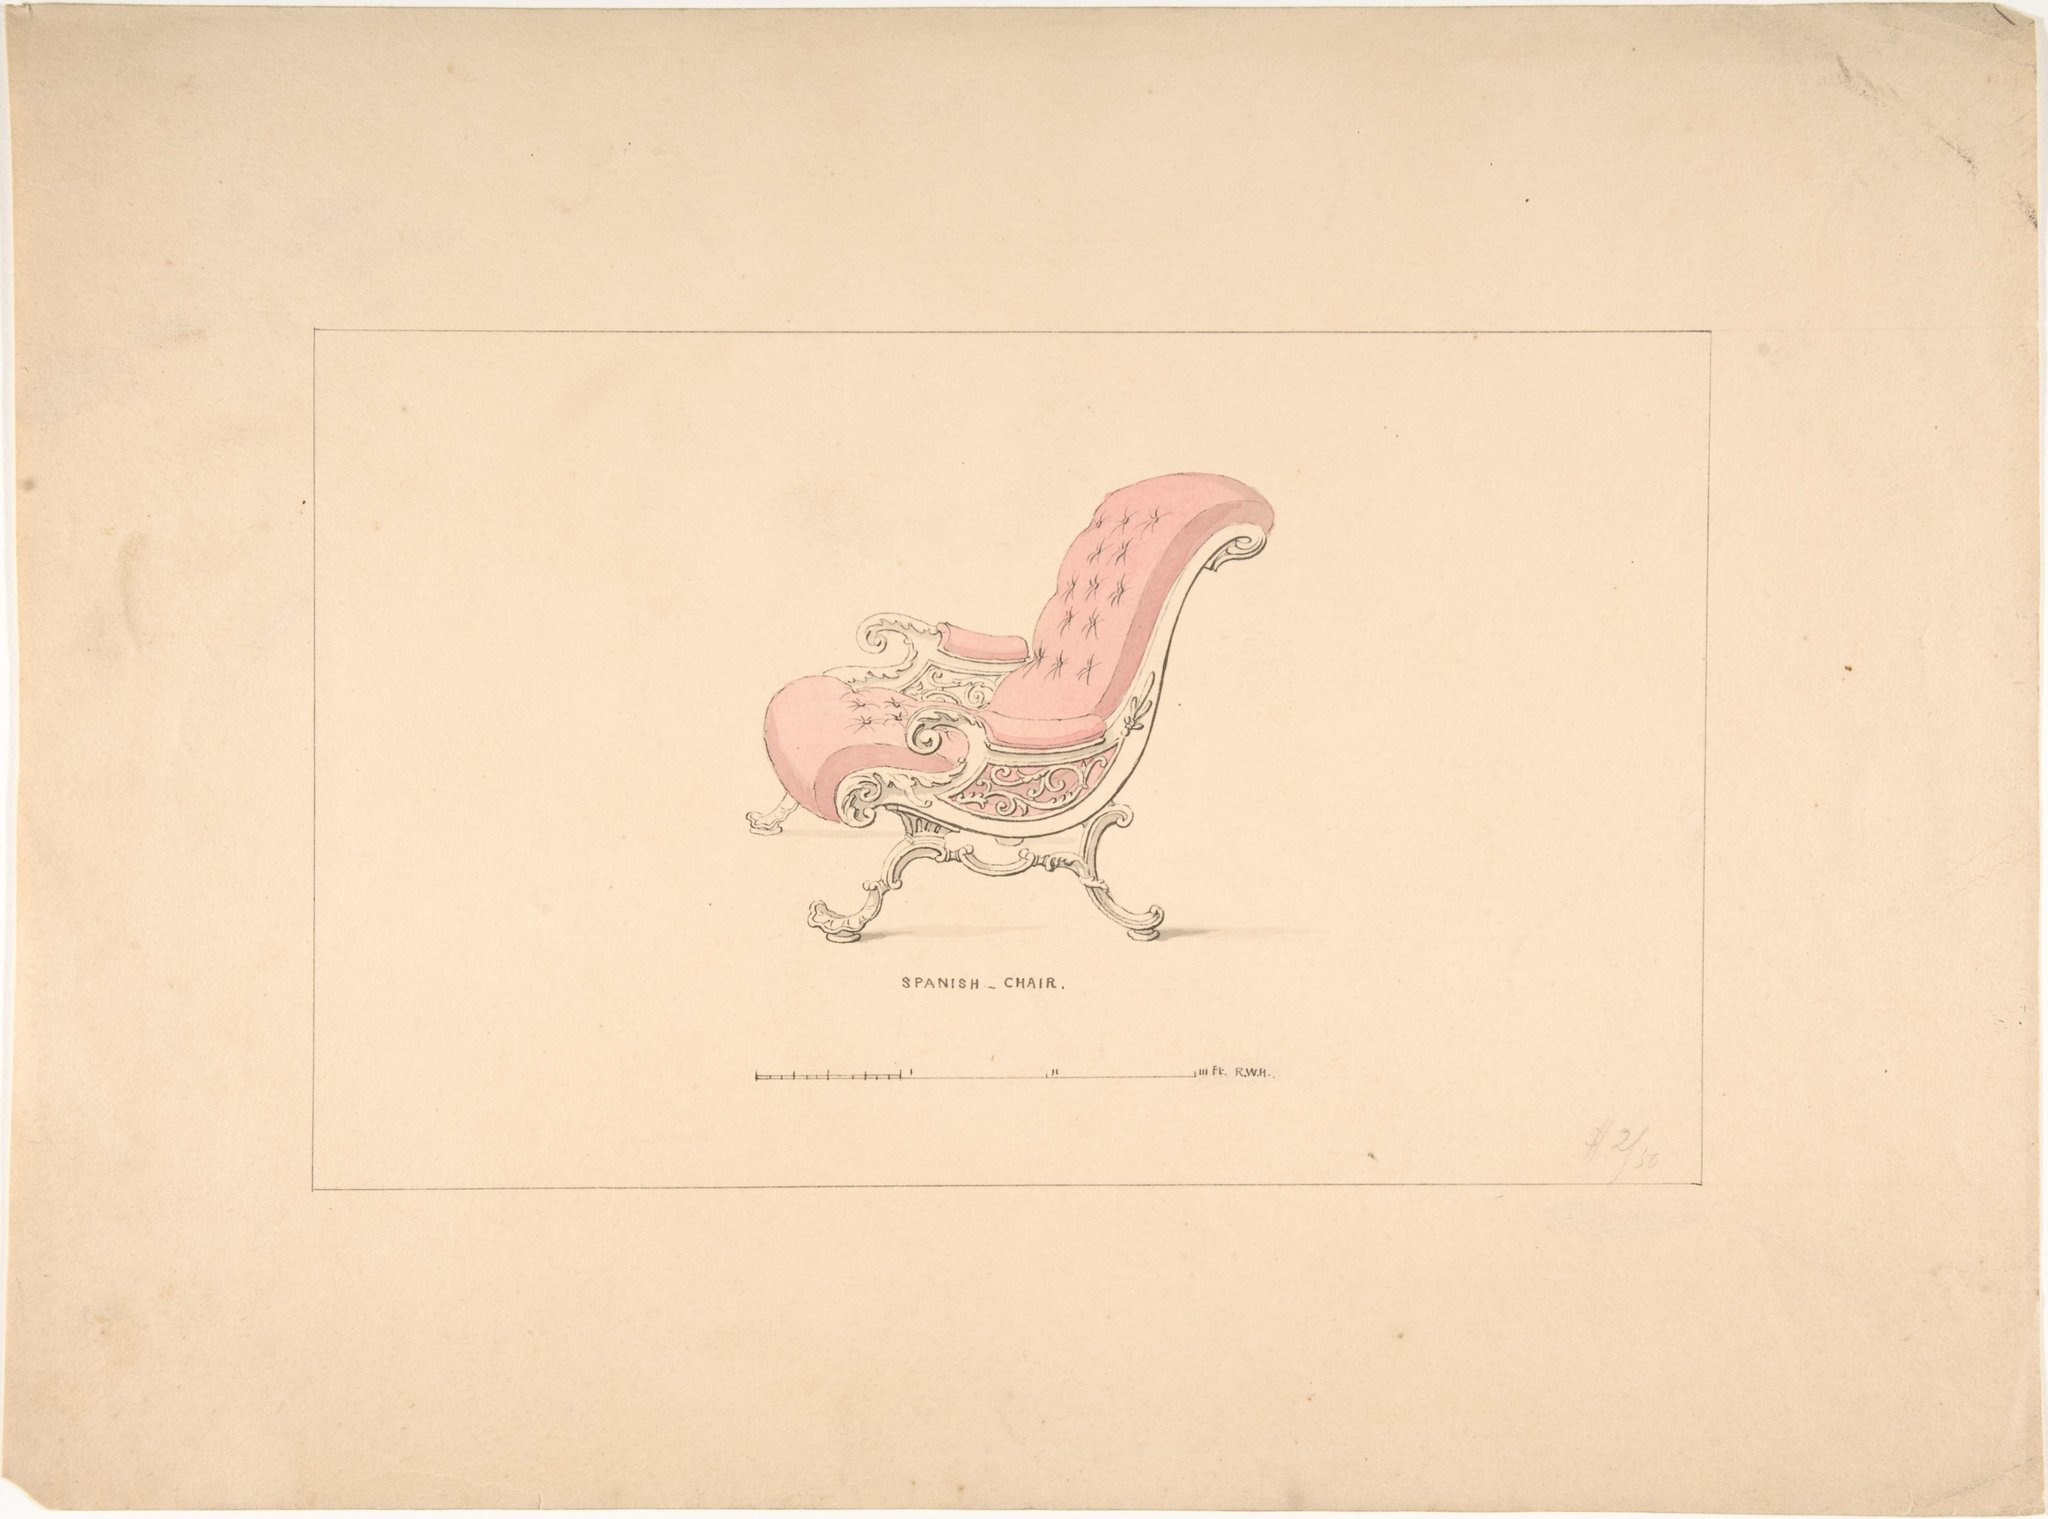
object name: drawing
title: Design for Spanish Chair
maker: robert william hume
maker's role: artist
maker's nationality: british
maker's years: 1816-1904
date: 1835-1900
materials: ink, watercolor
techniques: pen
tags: chairs